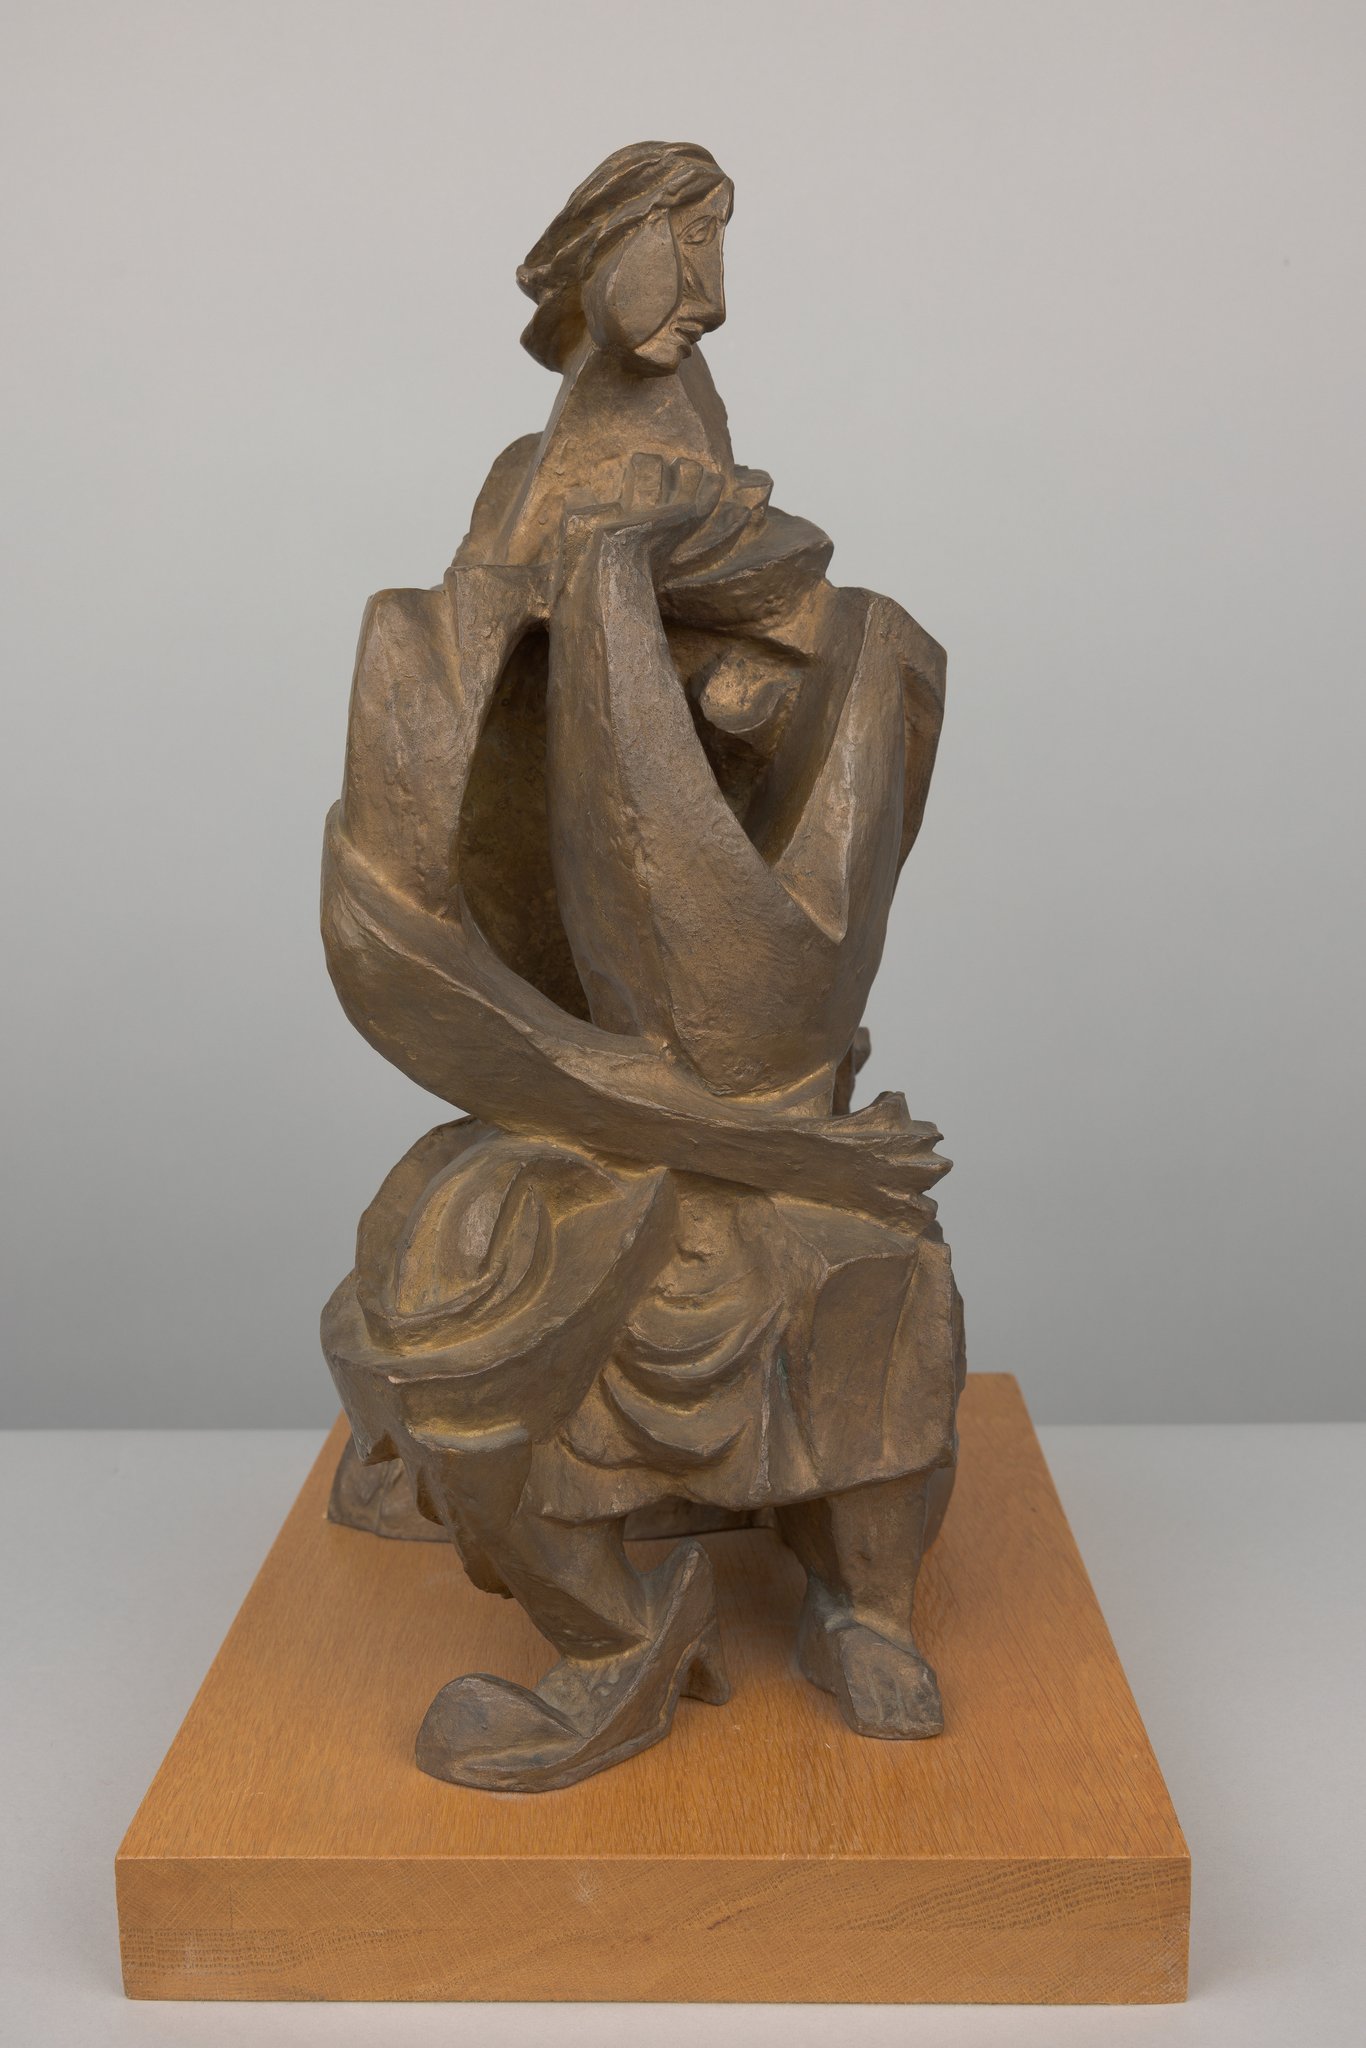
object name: sculpture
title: Spain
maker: herzl emanuel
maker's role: artist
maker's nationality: american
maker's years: 1914-2002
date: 1936-1937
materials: bronze